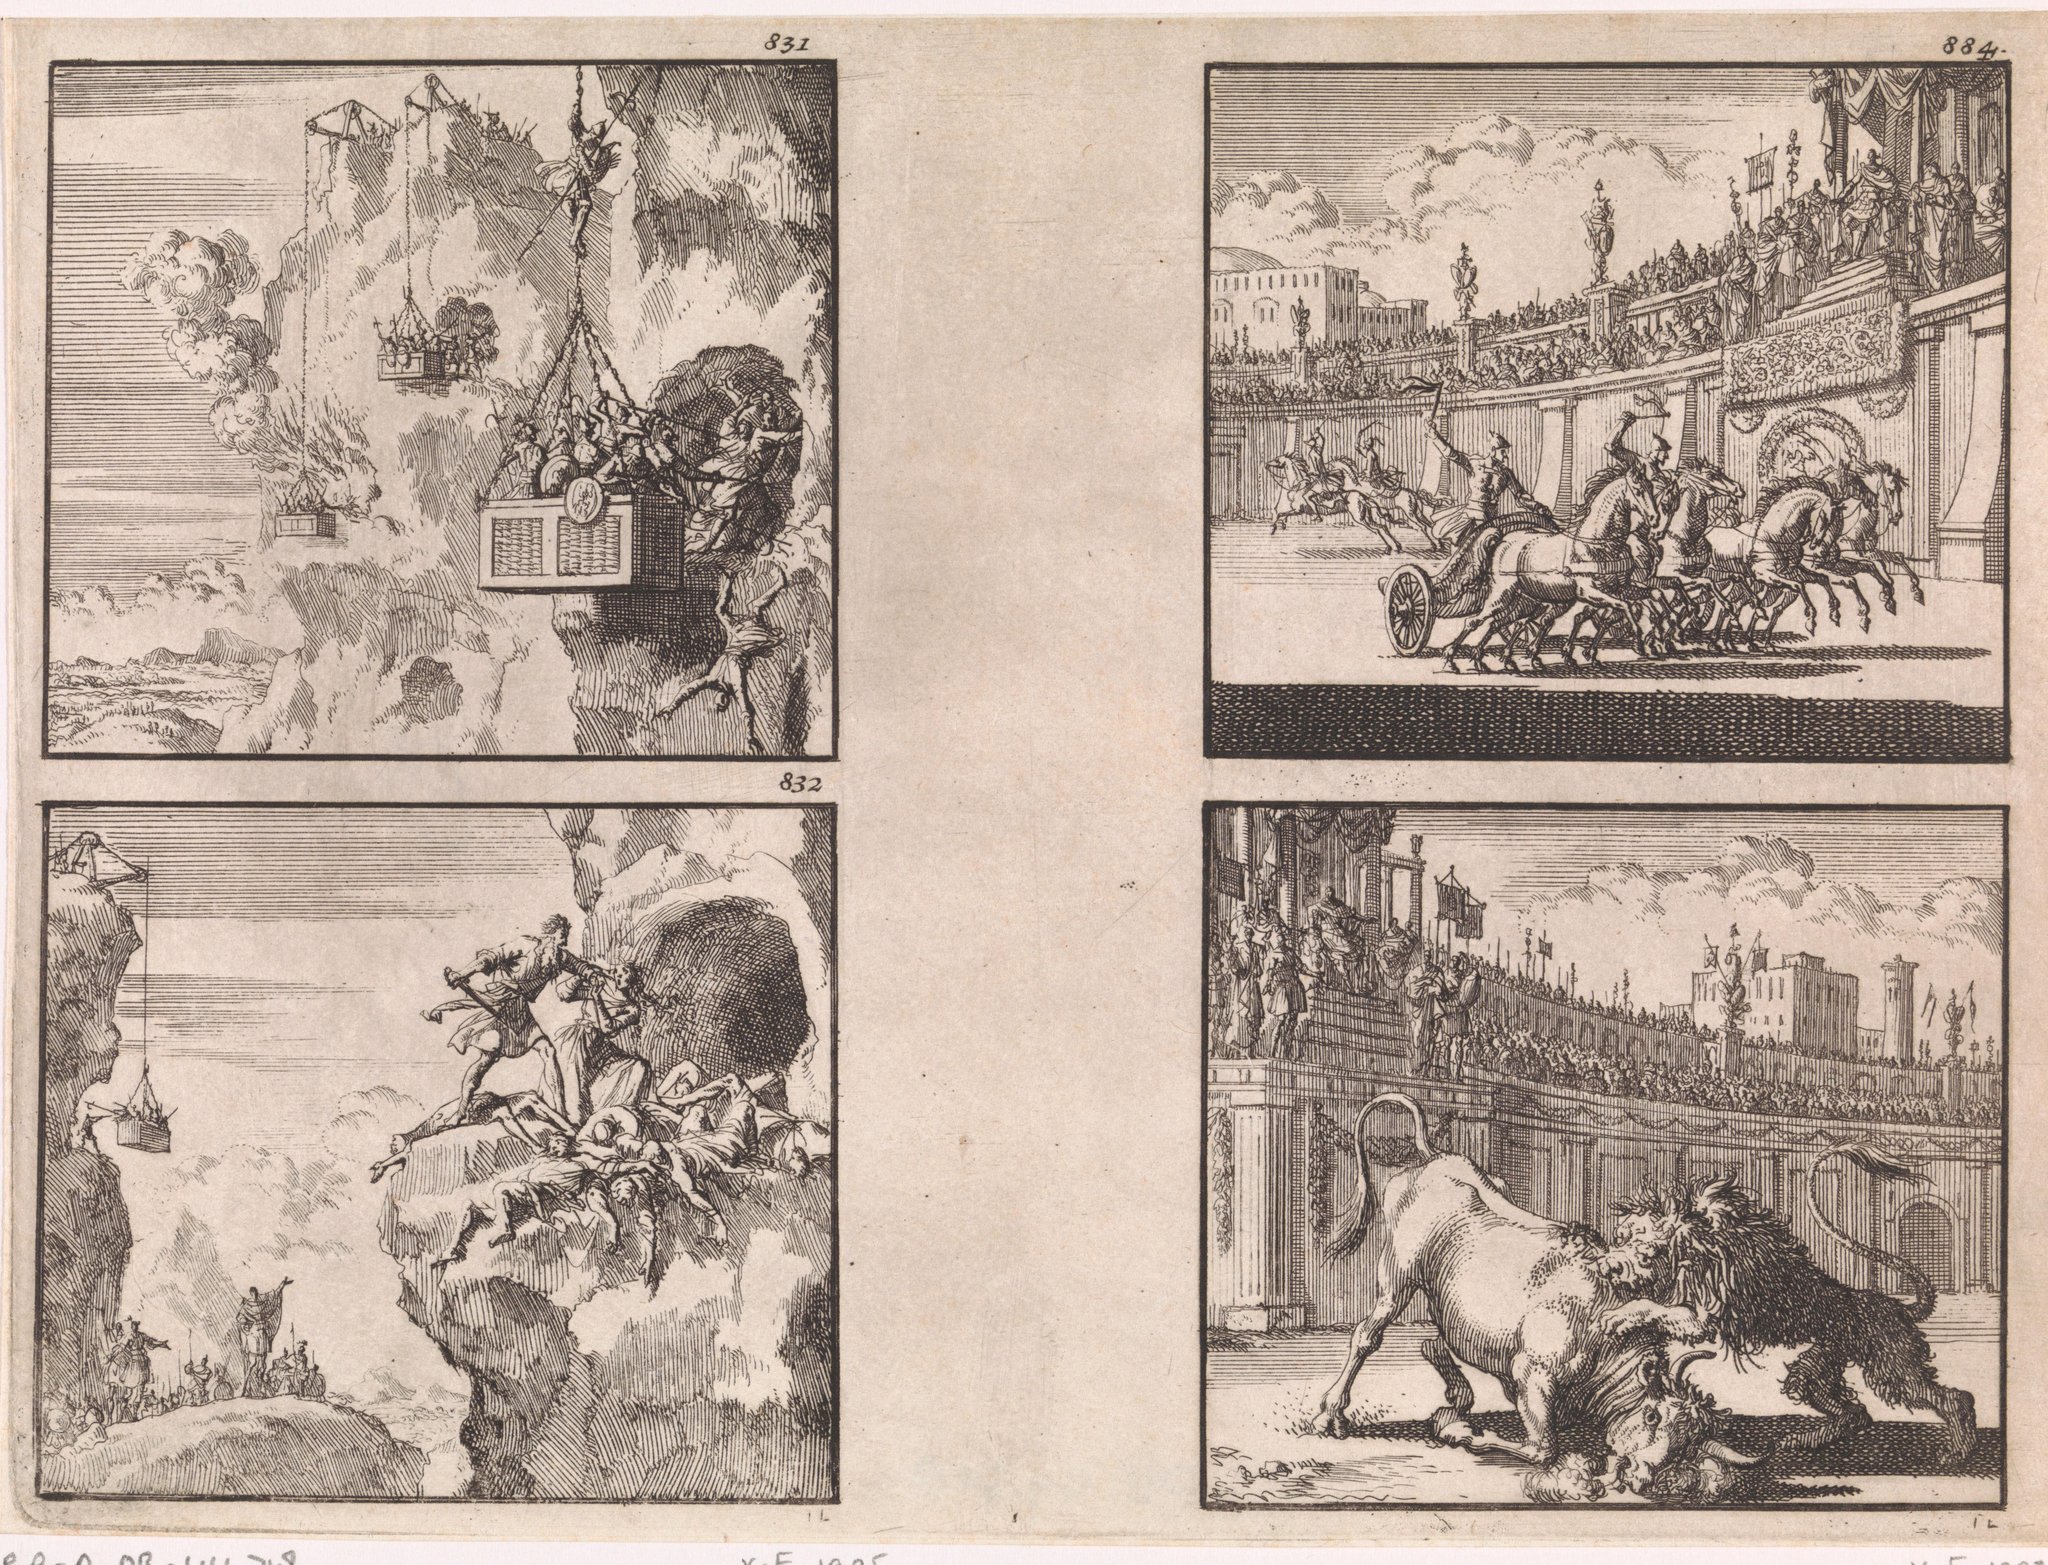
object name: print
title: Koning Herodes bestrijdt rovers die zich in spelonken hebben verscholen / Rover doodt zijn mederovers voor de ingang van een spelonk / Wagenrennen in een amfitheater te Jeruzalem / Strijd tussen een stier en een leeuw in een amfitheater te Jeruzalem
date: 1698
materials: paper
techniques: etching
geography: amsterdam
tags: wagon racing with two-wheeled vehicle, e.g.: chariot, sulky, bull, robber, theatre (building), cave, grotto, male persons from classical history (herod), sports, games ~ animals, beasts of prey, predatory animals: lion, killing ~ aggressive relationships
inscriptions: collector's mark: Lugt 2228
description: Illustraties uit: Josephus, Flavius. XX. boeken van de oude geschiedenissen der joden, 4 delen. Amsterdam: Barent Visscher, Willem de Coup, Willem van Lamsveld, Andries van Damme, 1698, dl. II.